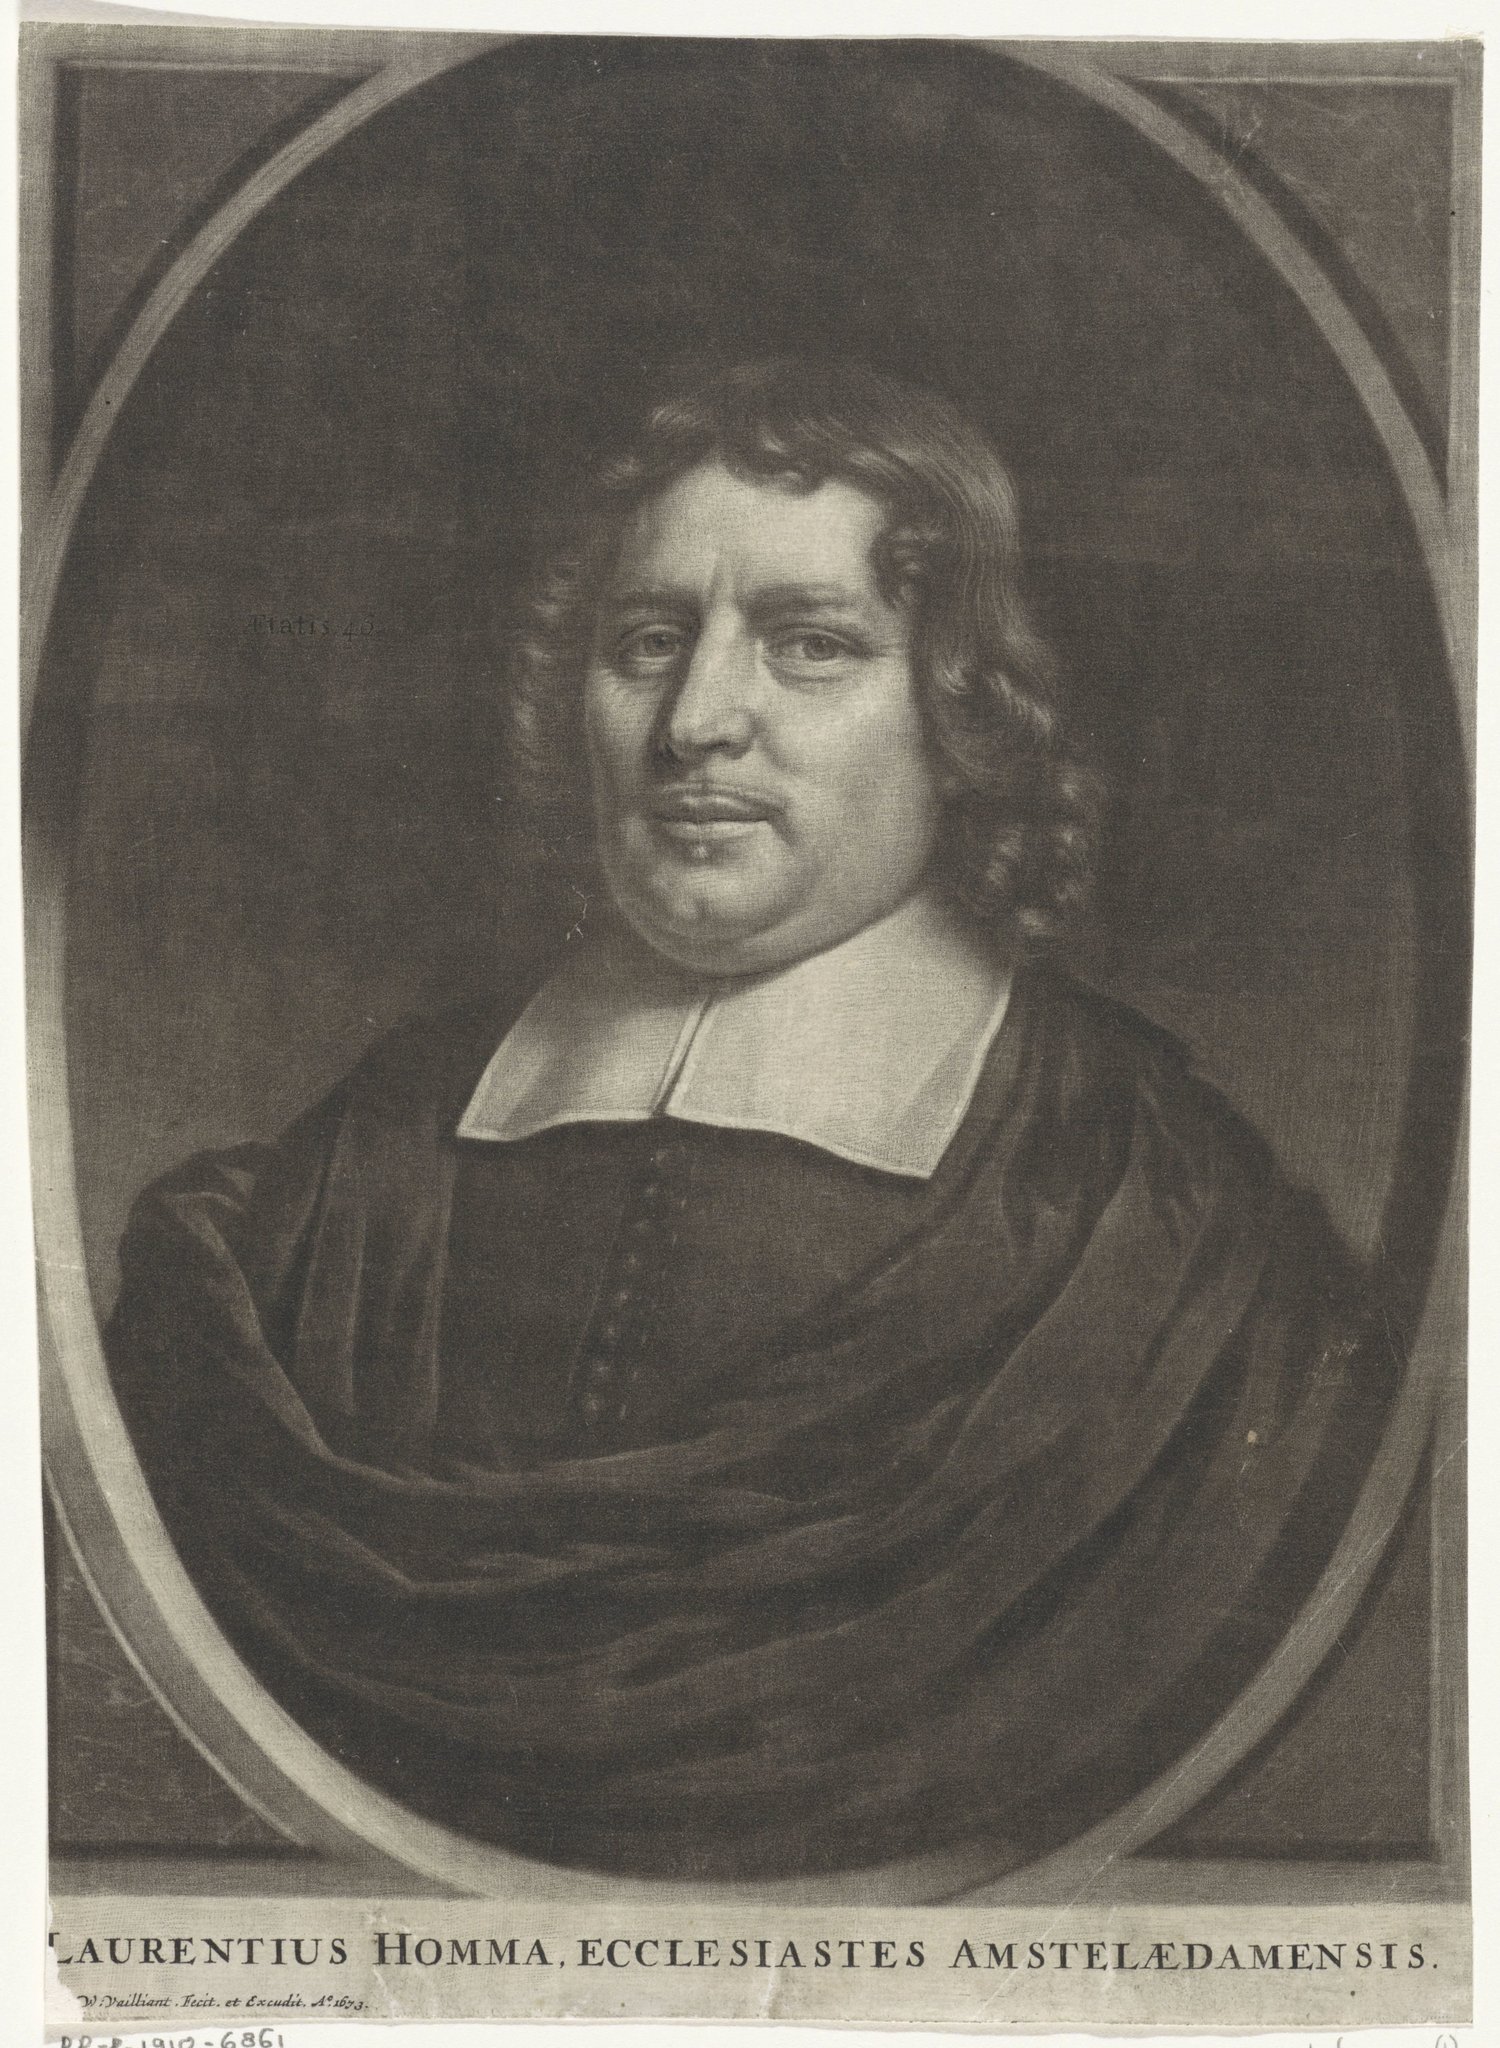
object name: print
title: Portret van de predikant Laurentius Homma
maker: wallerant vaillant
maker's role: draughtsman, painter, print maker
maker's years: 1623-1677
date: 1673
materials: paper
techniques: mezzotint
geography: amsterdam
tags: laurentius homma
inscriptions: collector's mark: Lugt 2036, collector's mark: Lugt 2228